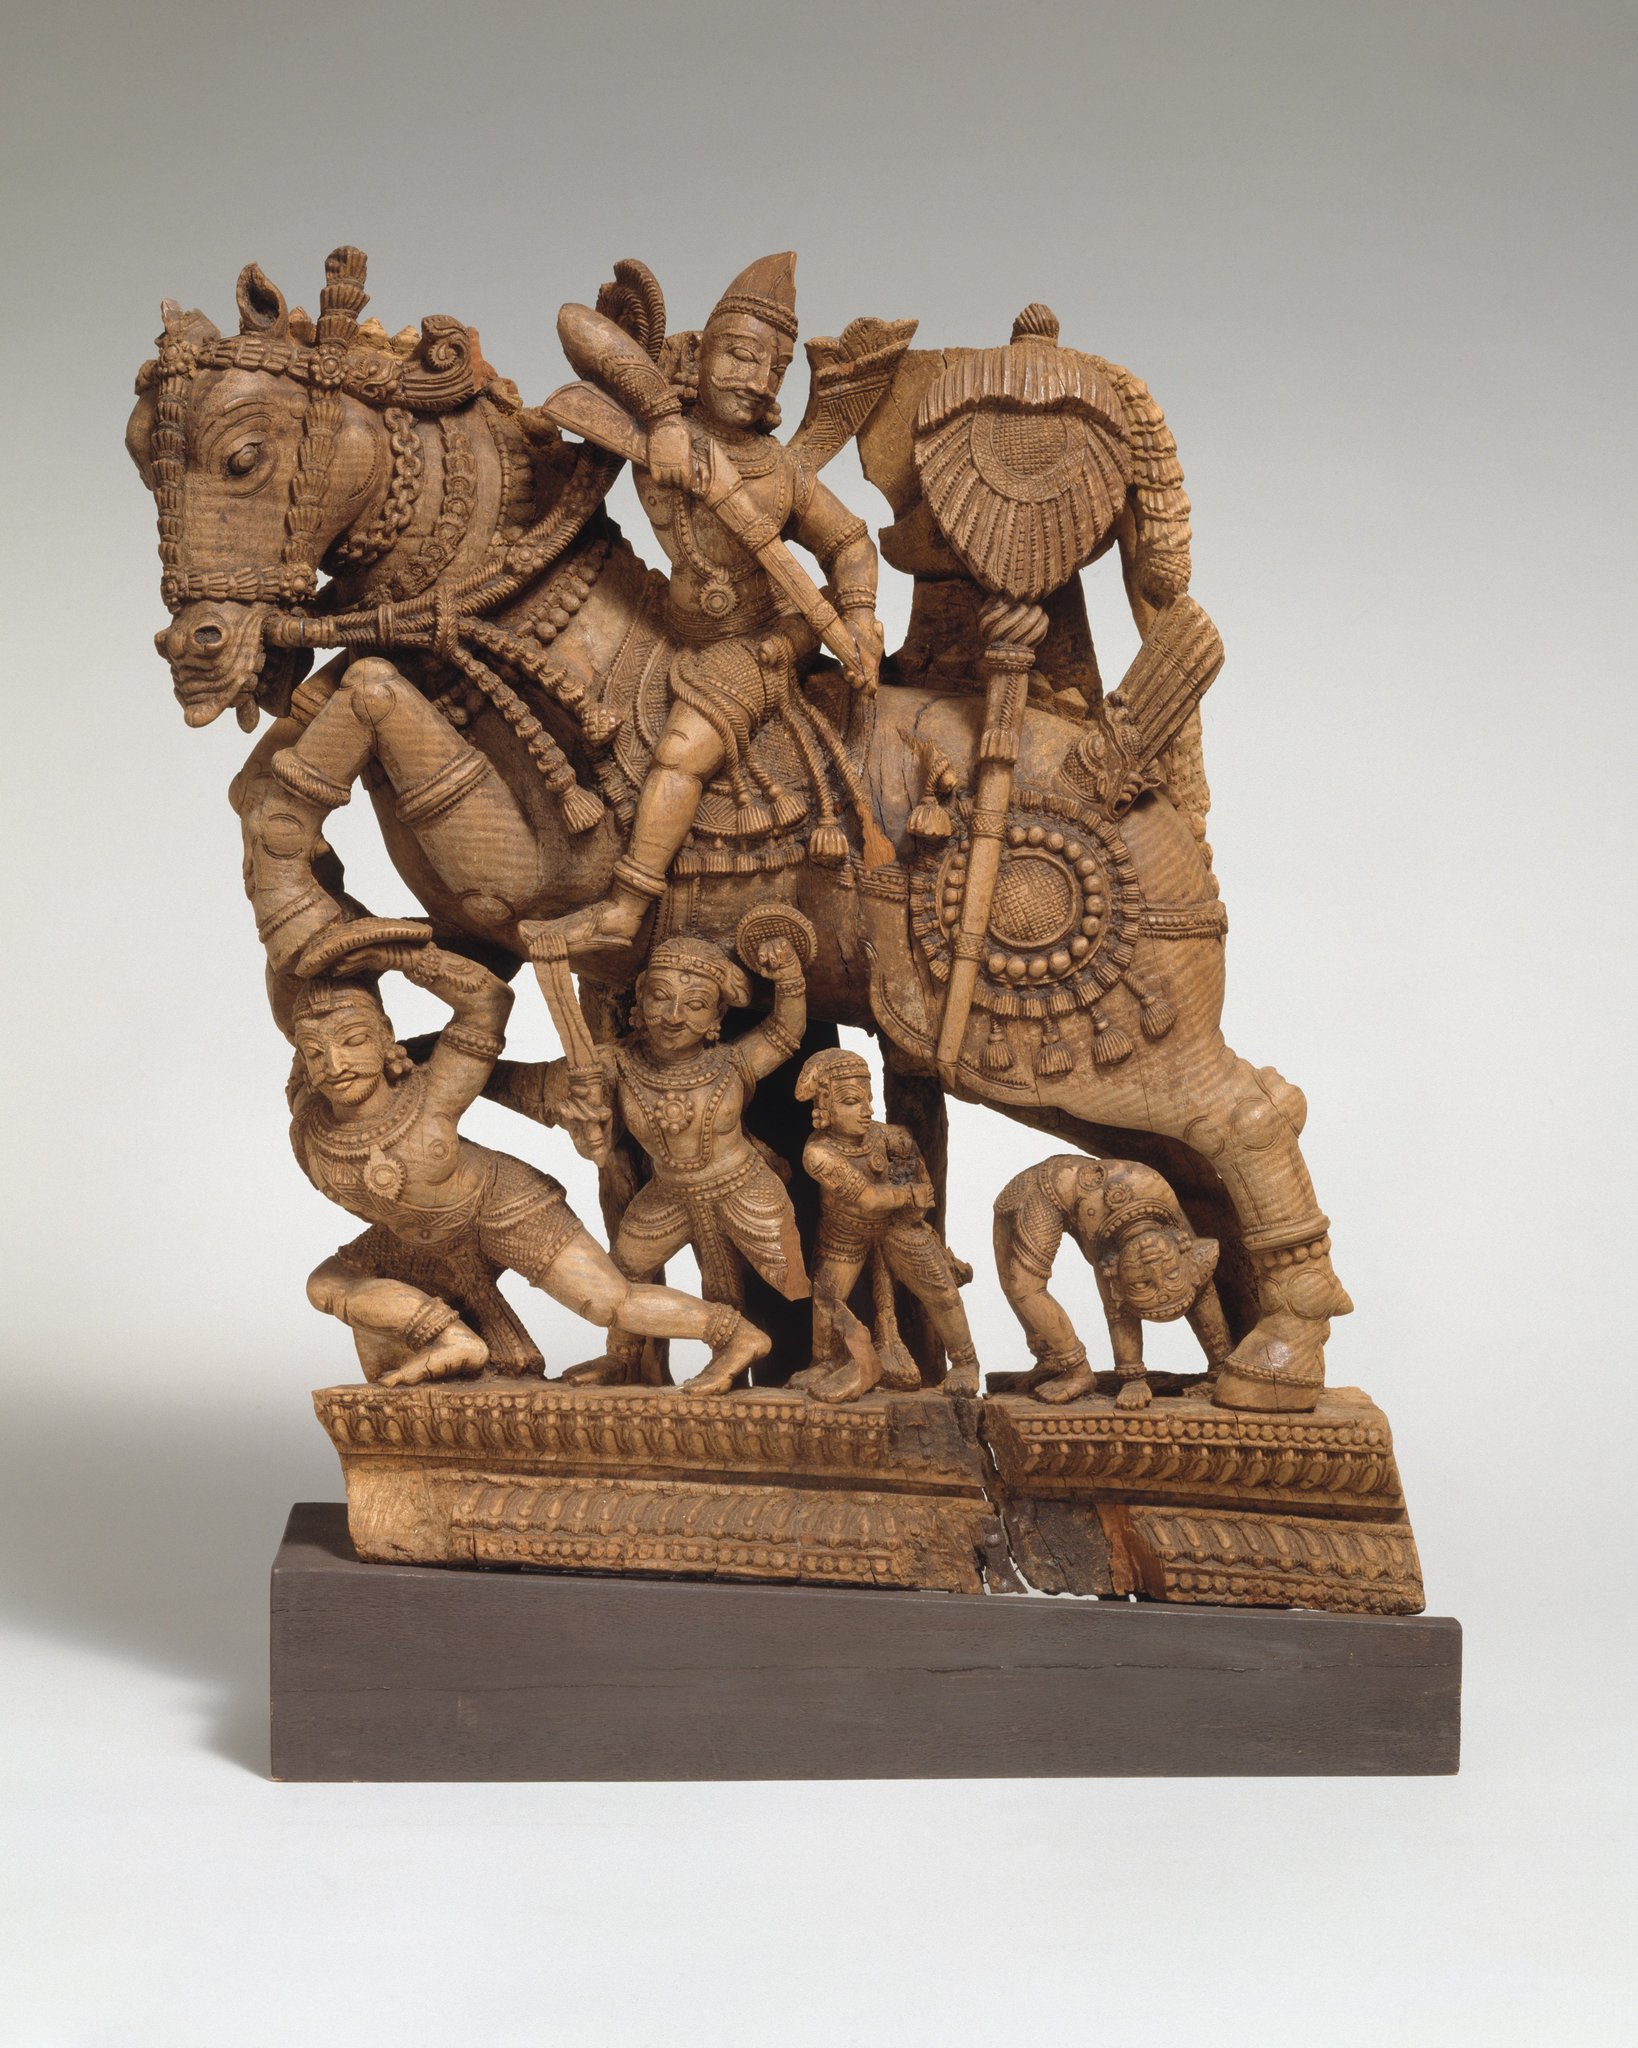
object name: relief panel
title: Panel from a Ritual Chariot: A Warrior on Horseback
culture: tamil nadu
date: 1601-1800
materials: wood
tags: firearms,men,horses